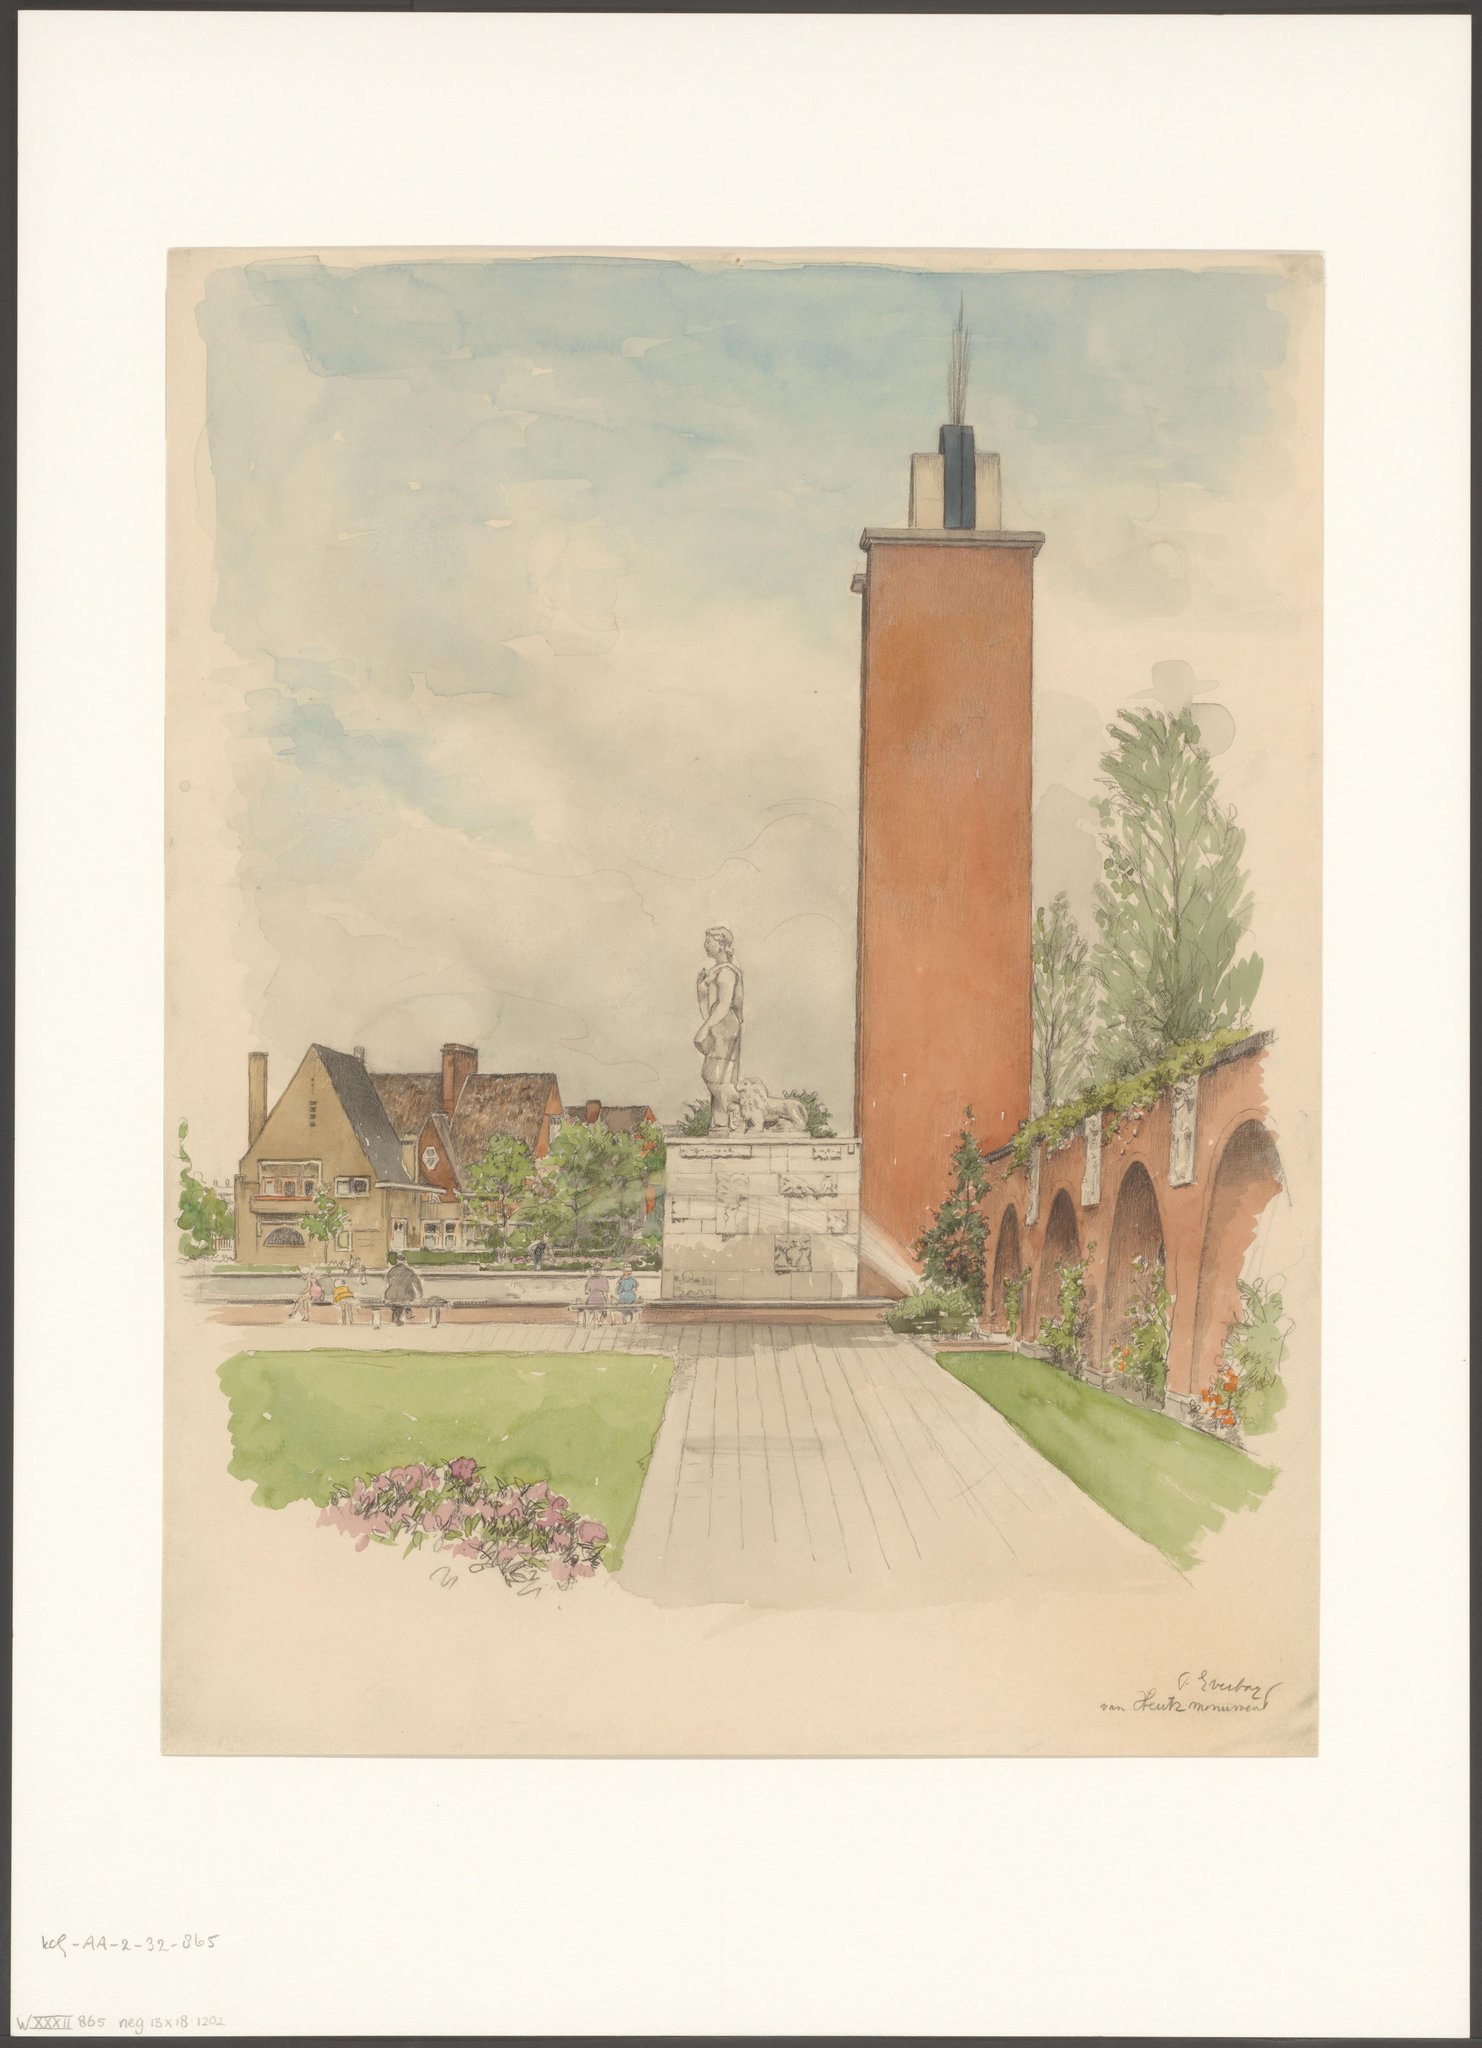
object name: drawing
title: Gezicht op het Monument Indië-Nederland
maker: frans everbag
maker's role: draughtsman, print maker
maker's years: 1877-1947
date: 1935-1947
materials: chalk, gouache, paper, pencil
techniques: brush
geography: amsterdam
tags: square, place, circus, etc., city-view in general; 'veduta', river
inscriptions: collector's mark: Lugt 800a, inscription: ‘van Heutz monument’, signature: ‘F Everbag’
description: Tekening binnen de Atlas Van Eck ingedeeld op wijknummer 32.